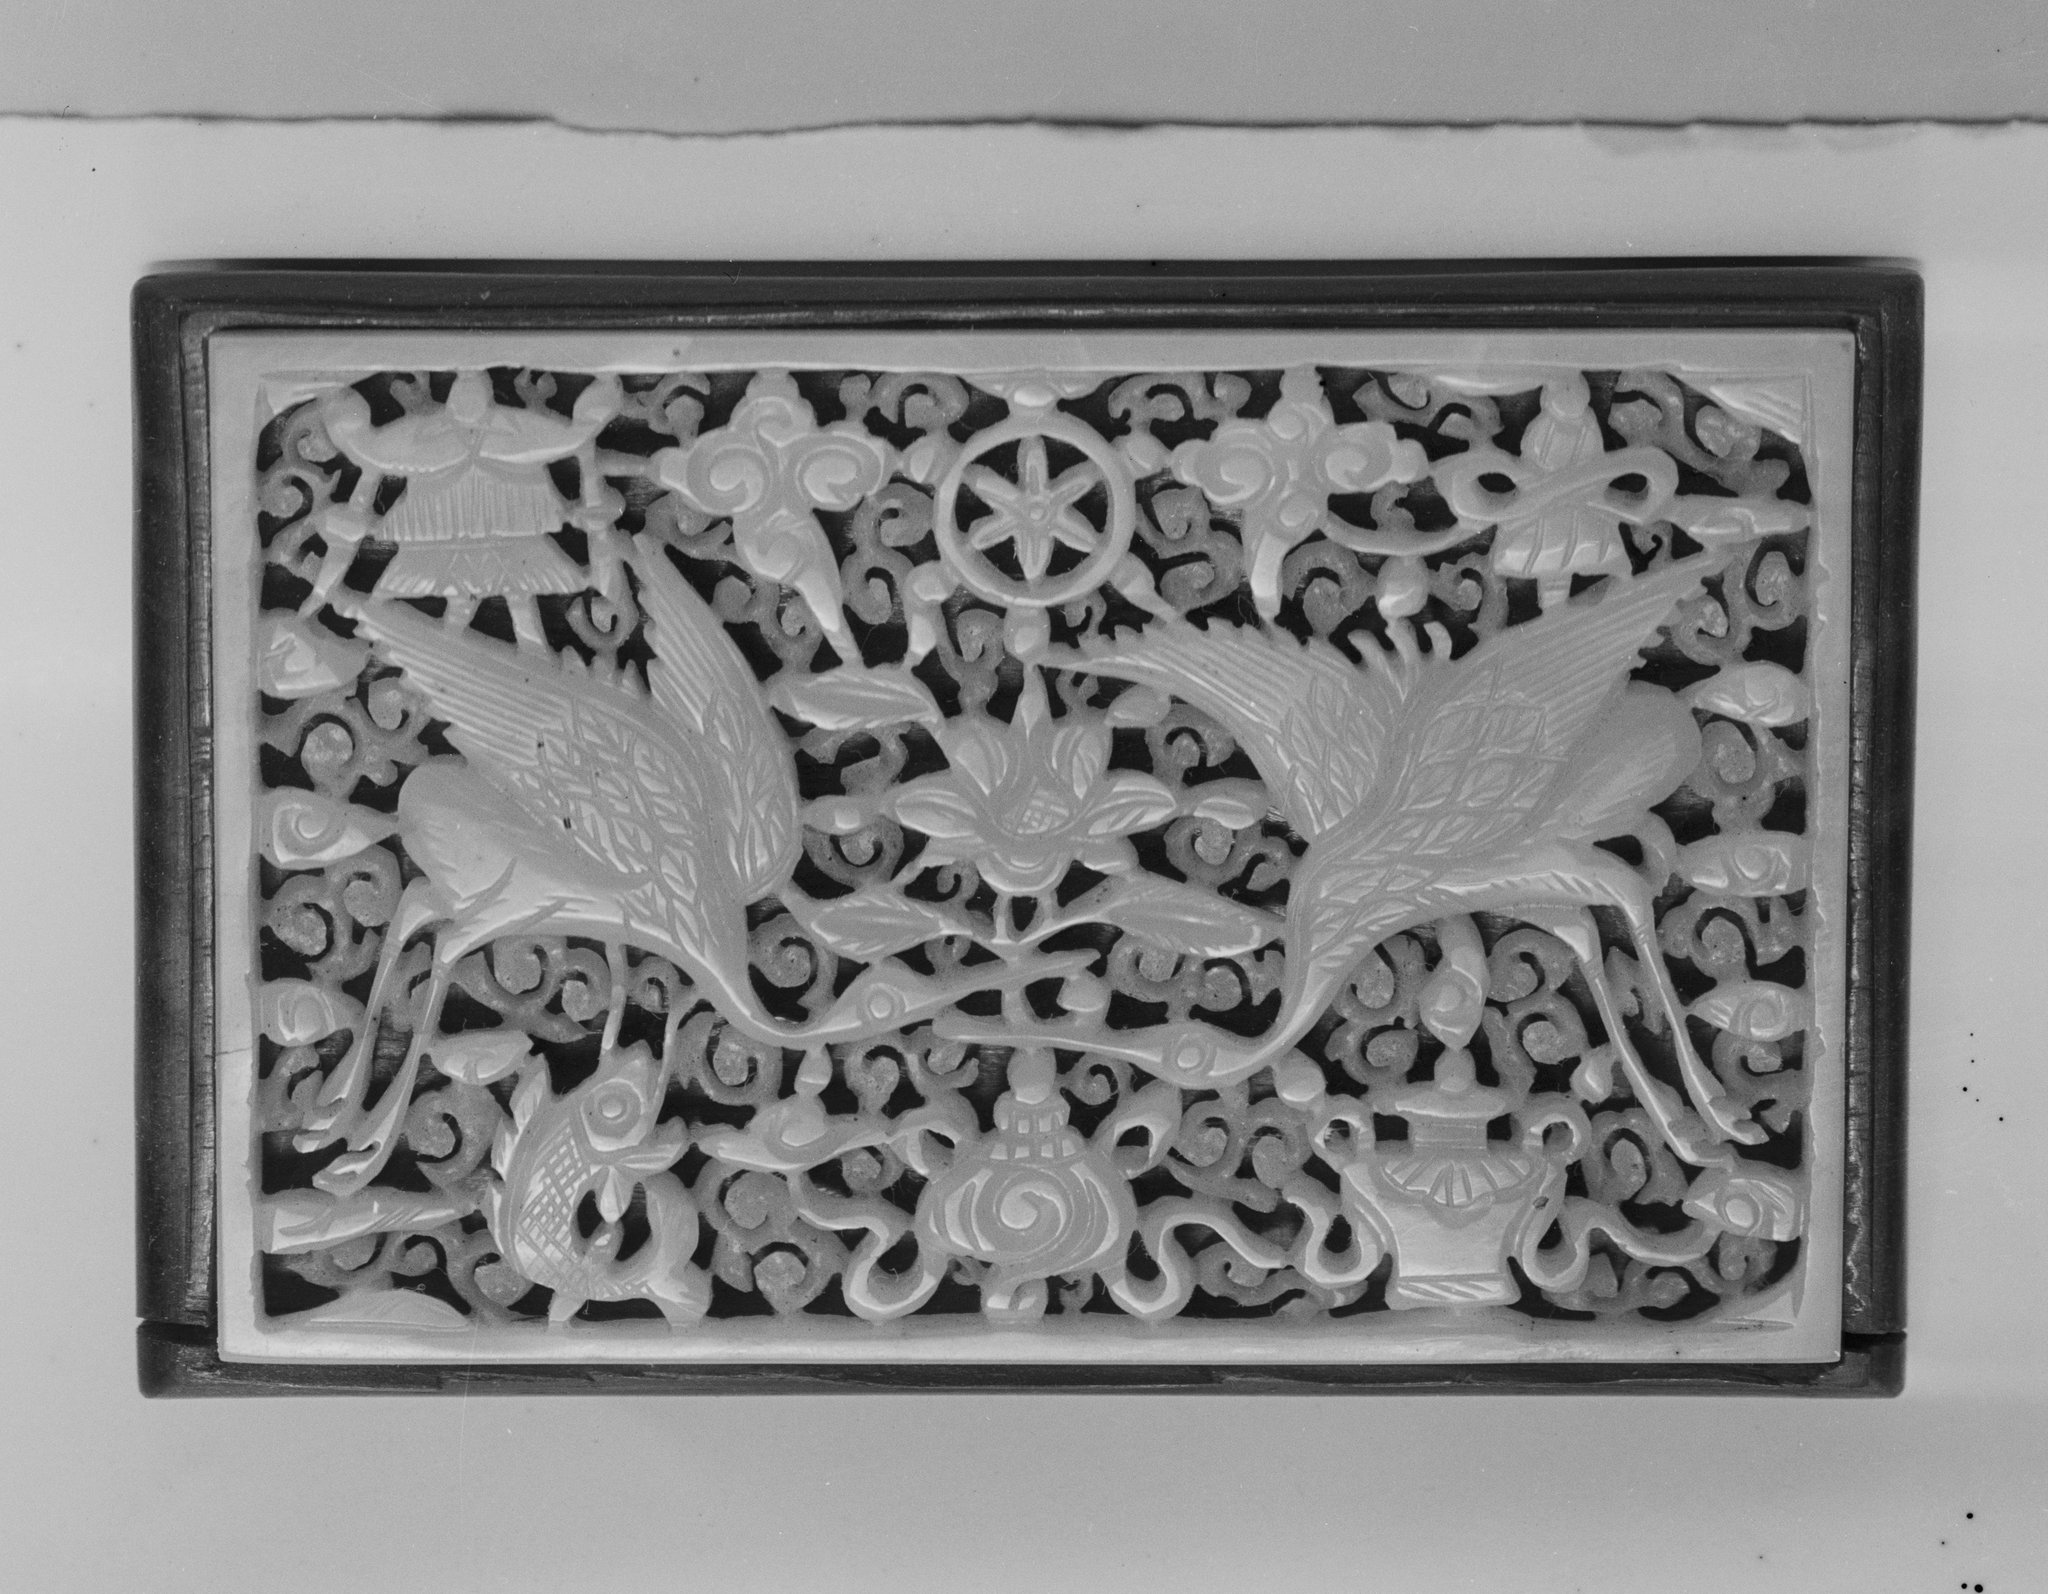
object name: pen rest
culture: chinese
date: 1736-1795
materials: jade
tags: birds,fish,flowers